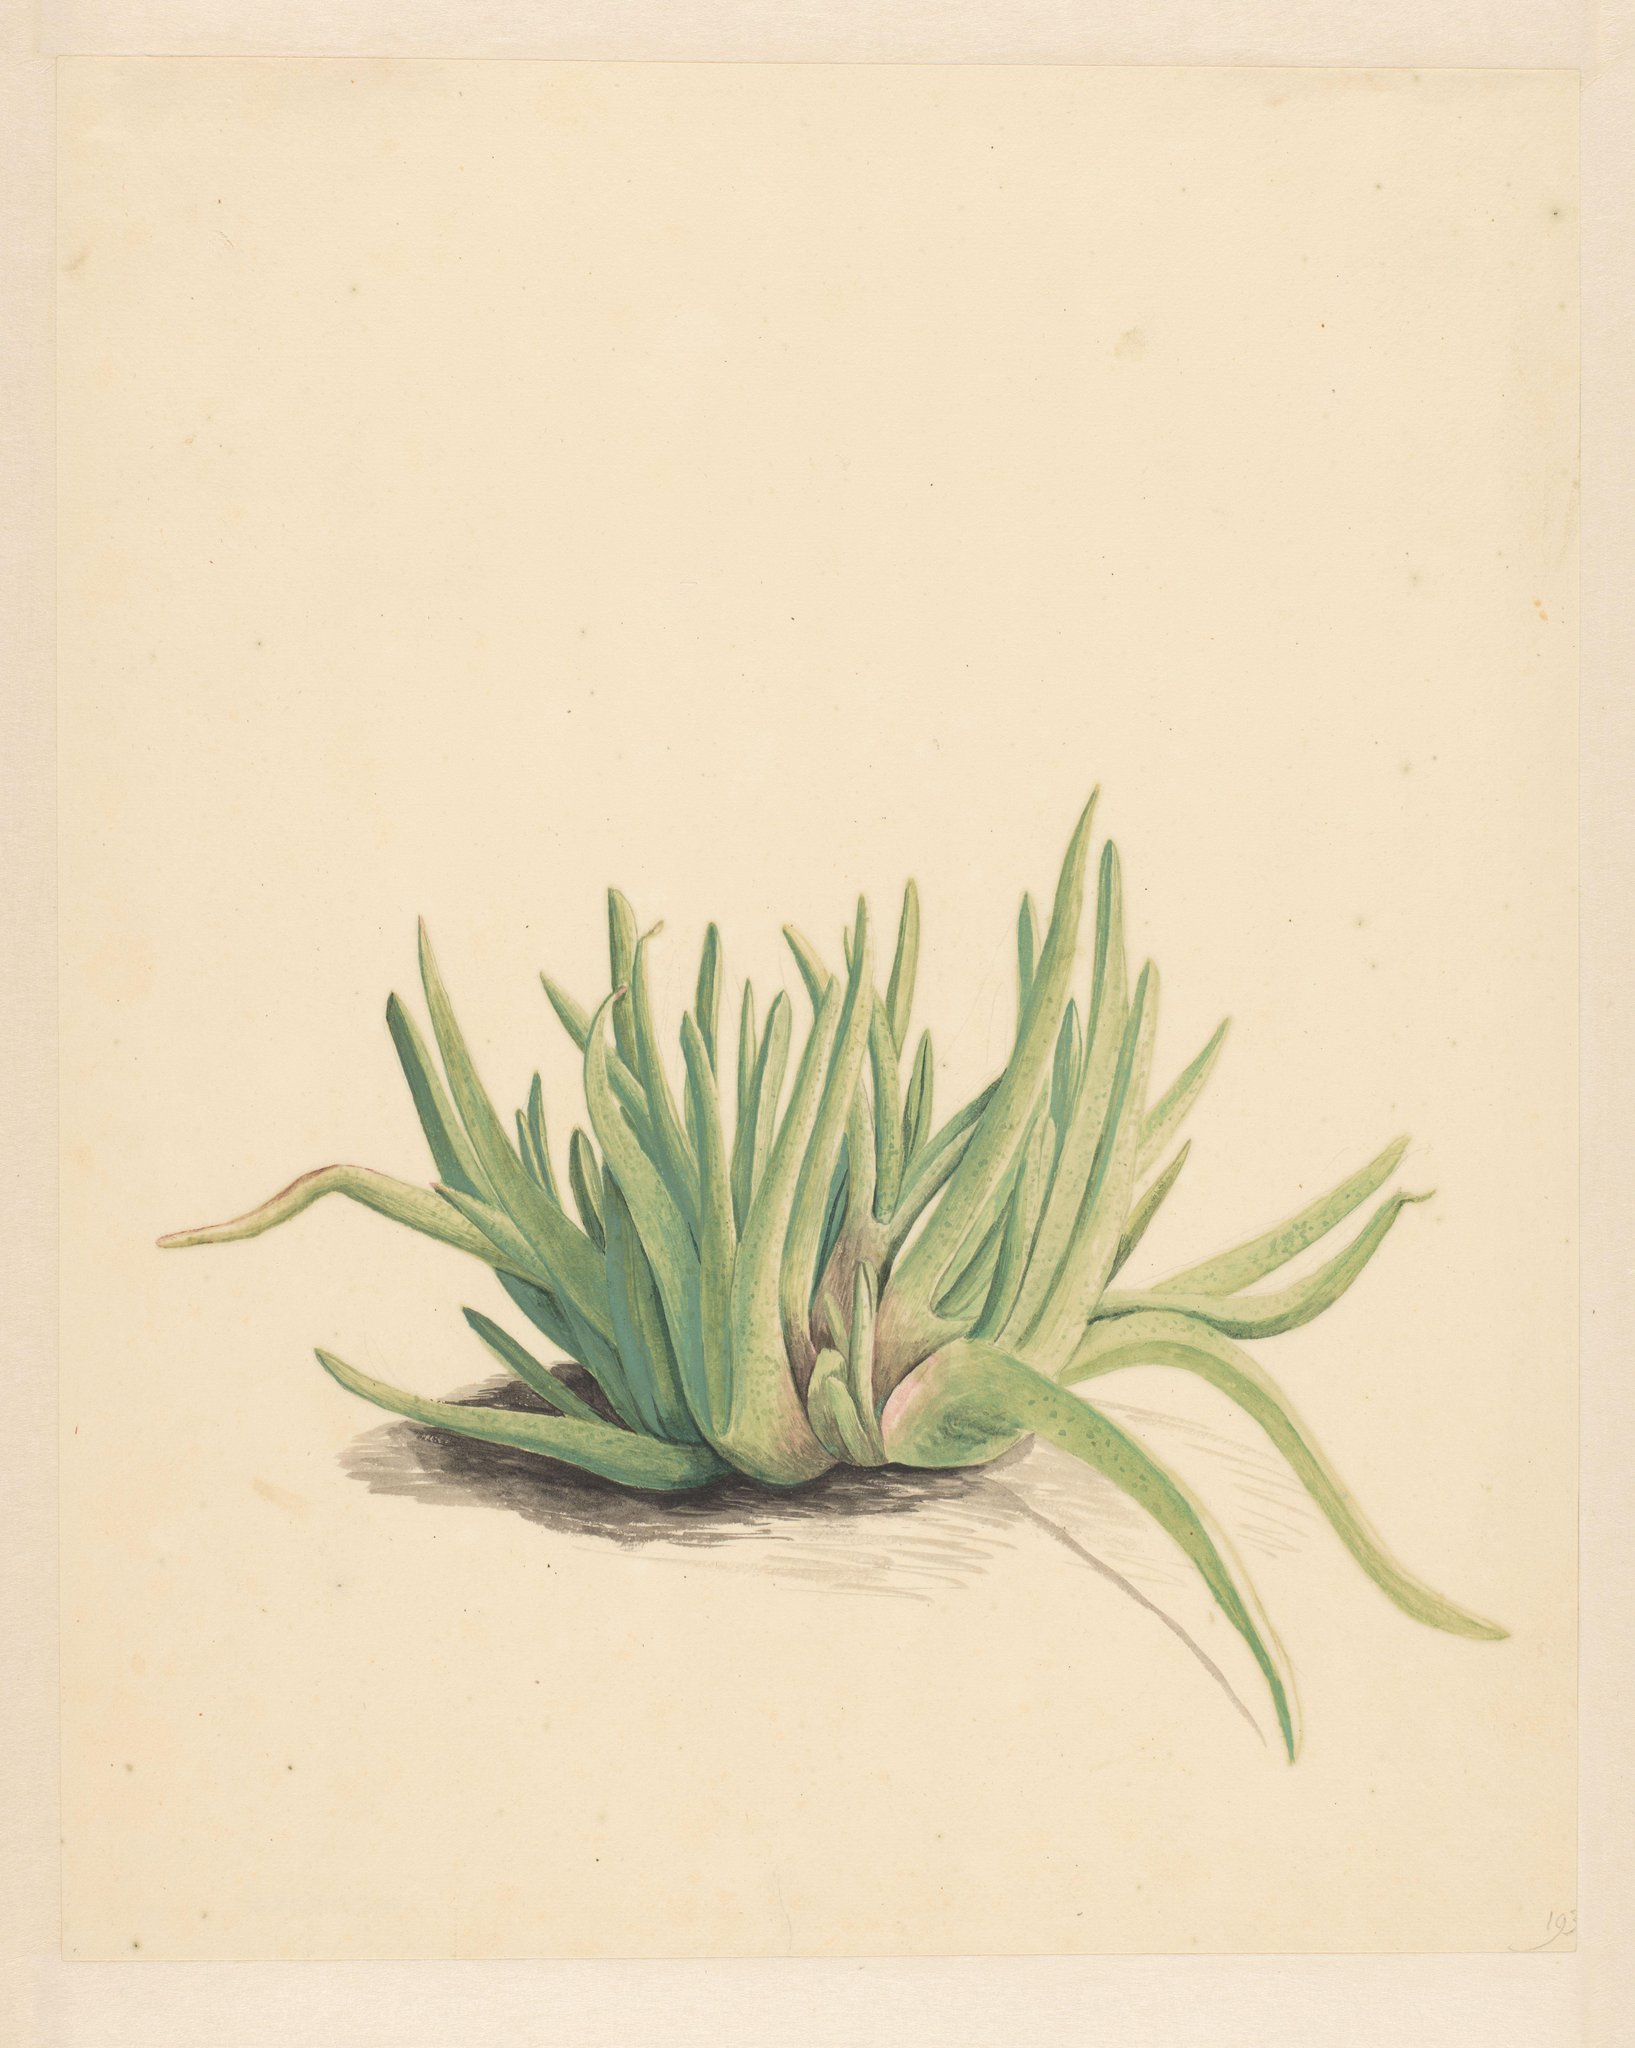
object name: drawing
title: IJskruid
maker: vincent jansz. van der vinne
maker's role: draughtsman, print maker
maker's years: 1736-1811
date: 1746-1811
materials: paint, paper, pencil, watercolor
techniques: brush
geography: netherlands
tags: flowers: ice plant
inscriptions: inscription: ‘Mesembryanthenum’